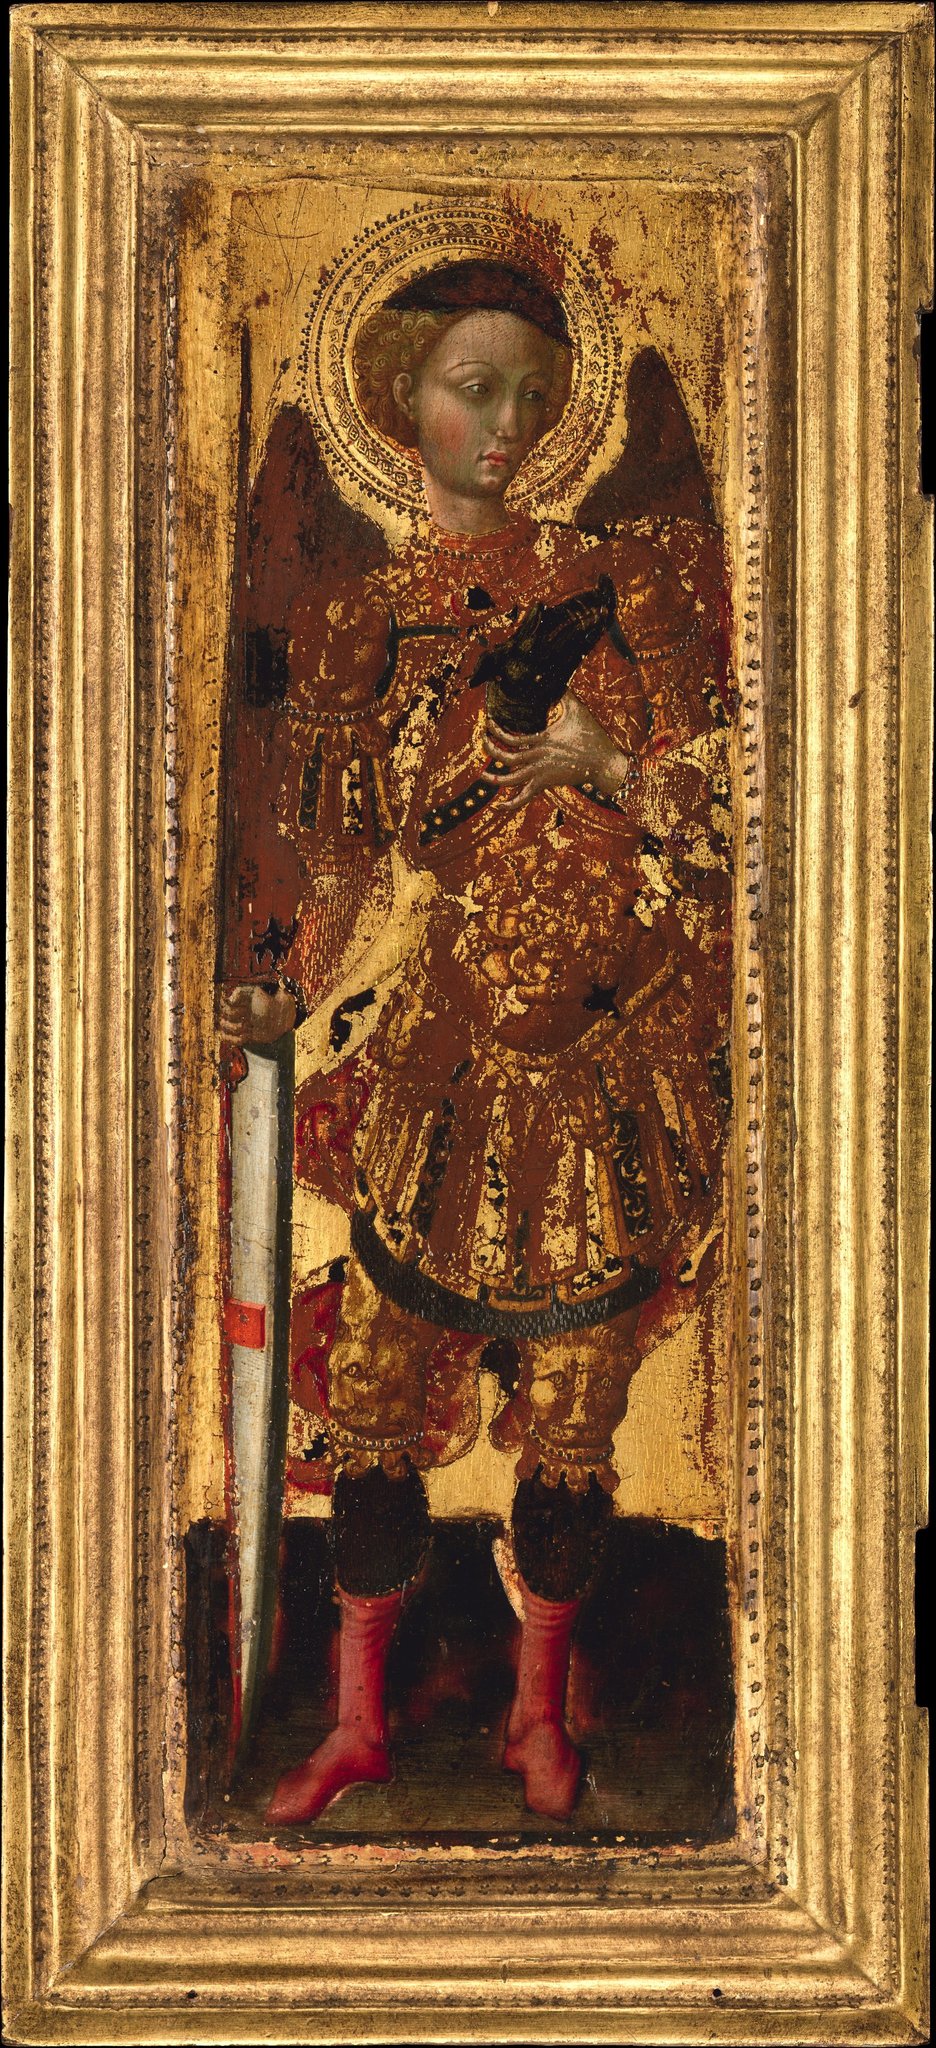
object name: painting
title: Saint Michael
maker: pietro di giovanni d'ambrogio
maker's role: artist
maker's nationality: italian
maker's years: 1410-1449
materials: gold leaf, silver, paint, wood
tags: saint michael